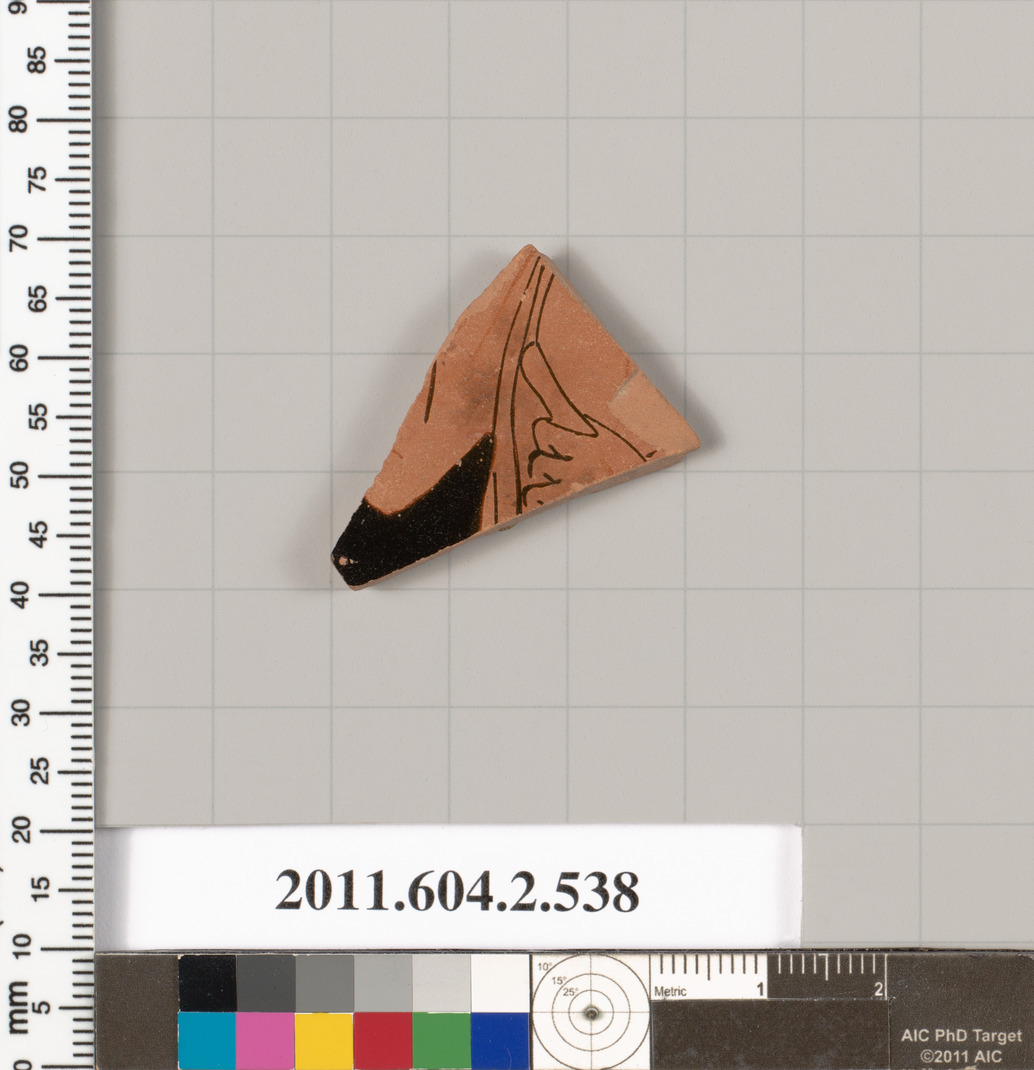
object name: column krater fragment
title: Terracotta fragment of a column-krater (bowl for mixing wine and water)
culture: greek, attic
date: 460-440 BCE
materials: terracotta